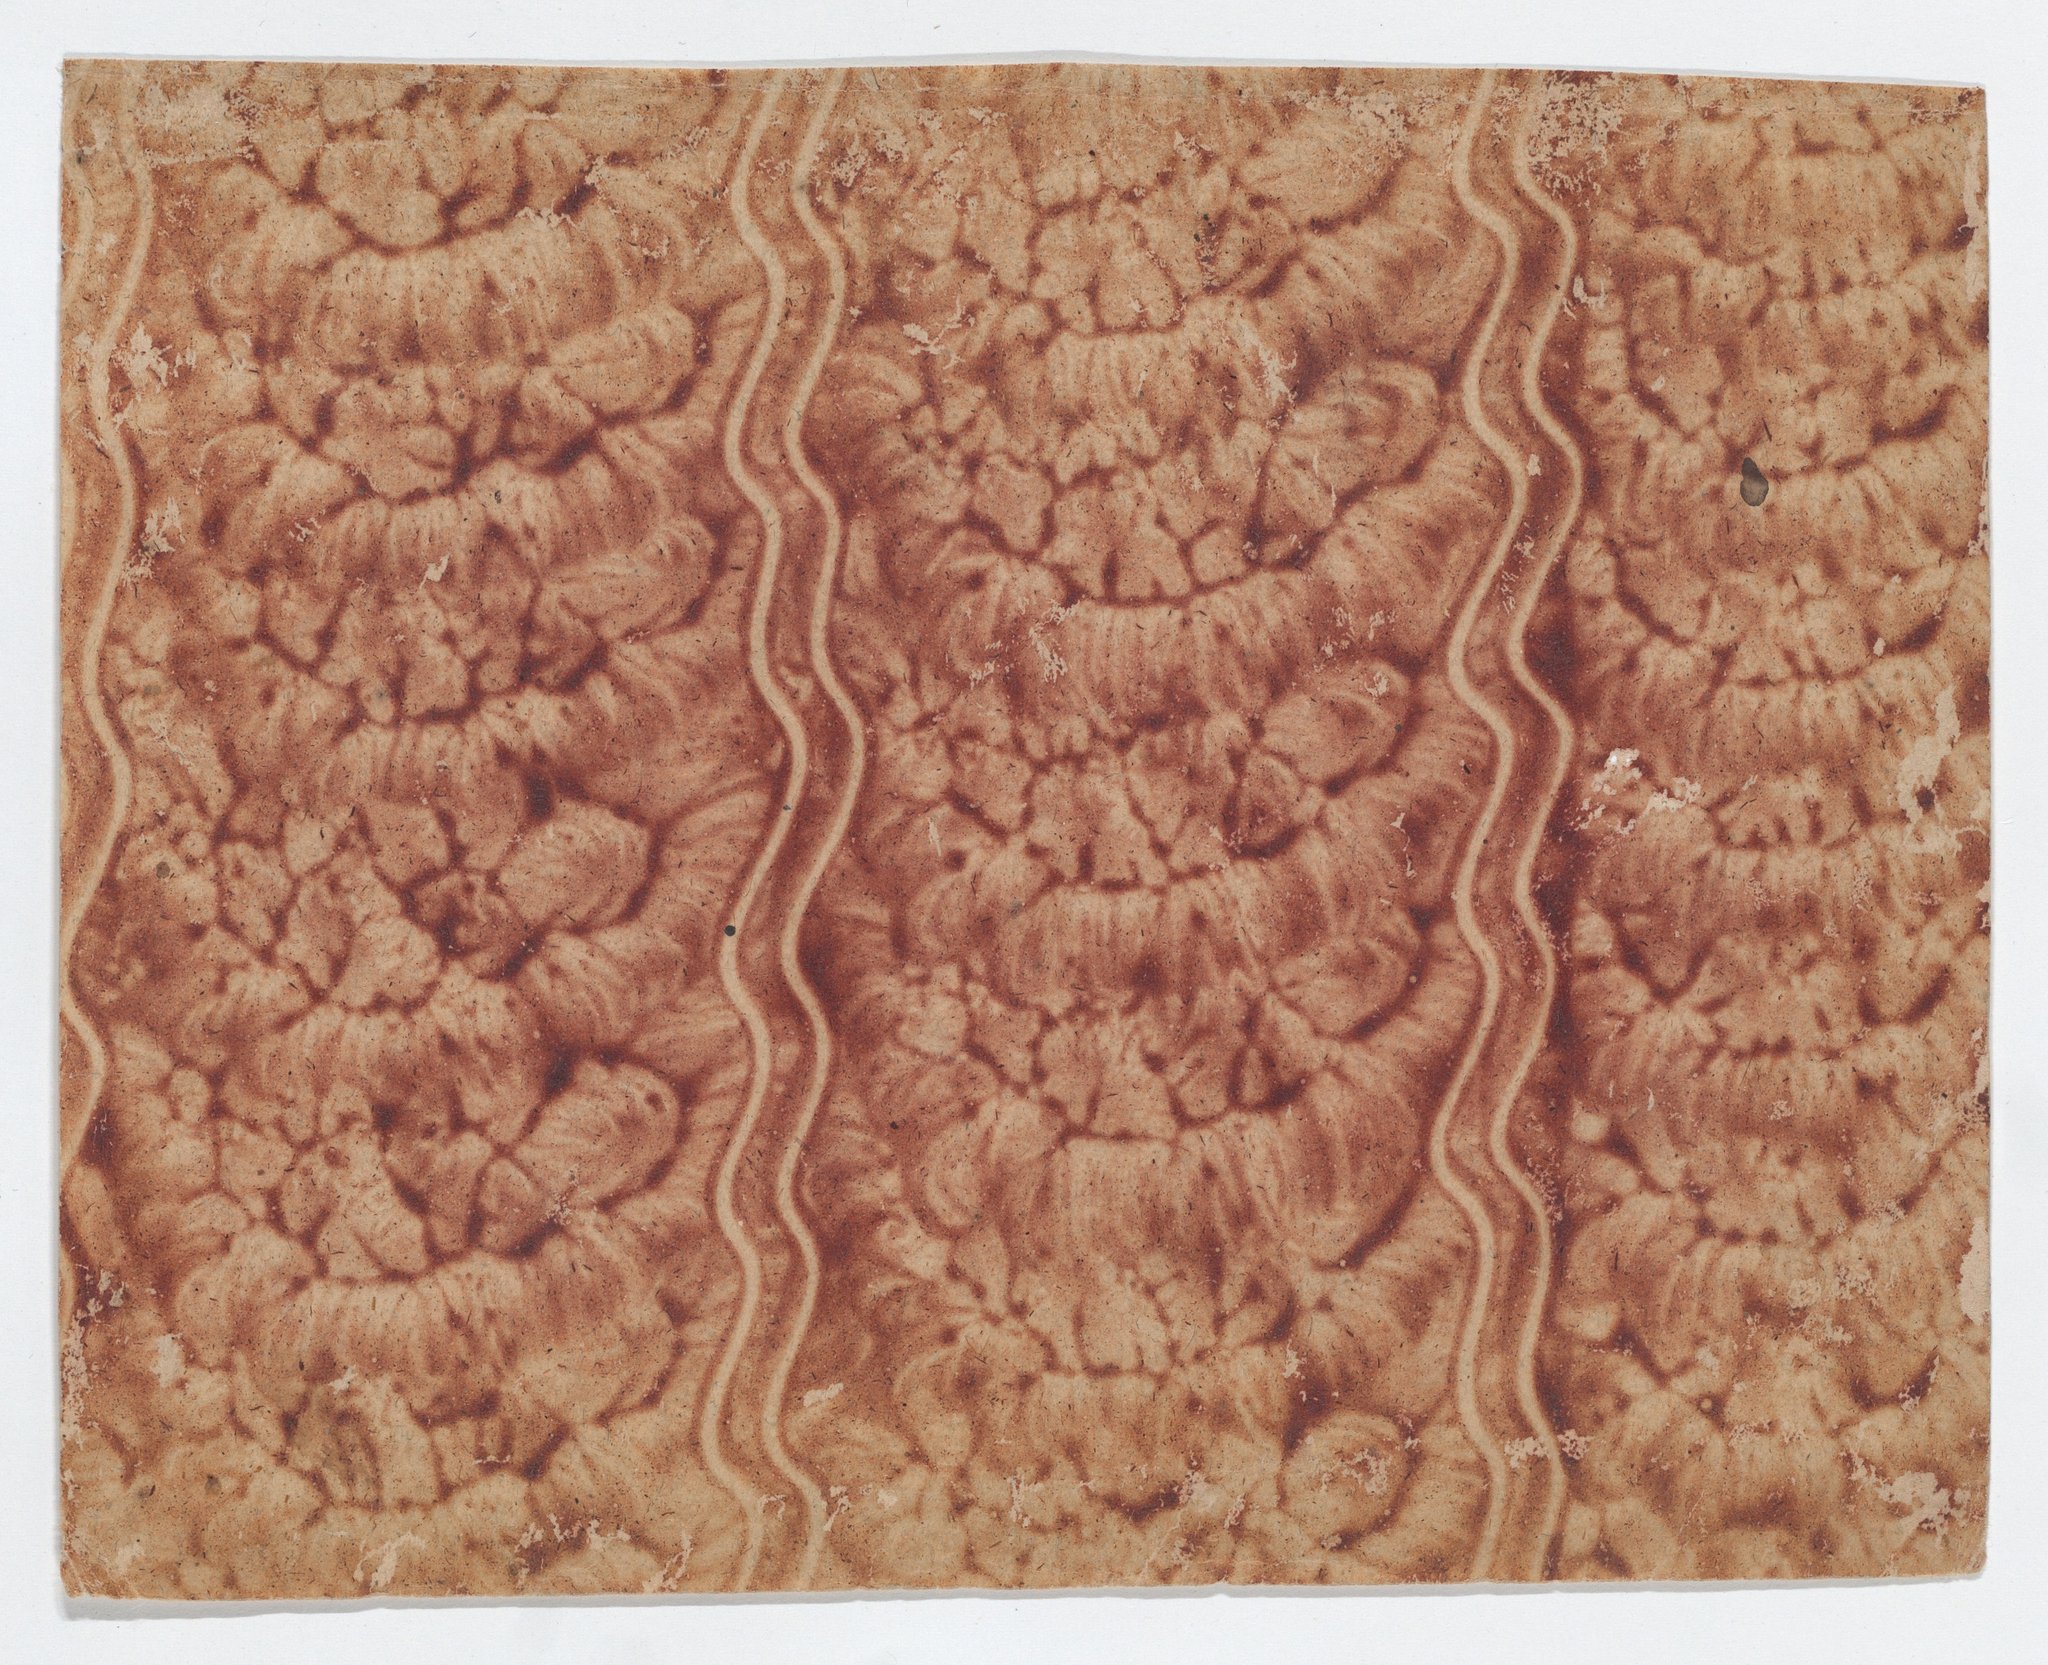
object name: print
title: Red paste paper with wavy line design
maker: Anonymous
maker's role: artist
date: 1701-1800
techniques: relief print